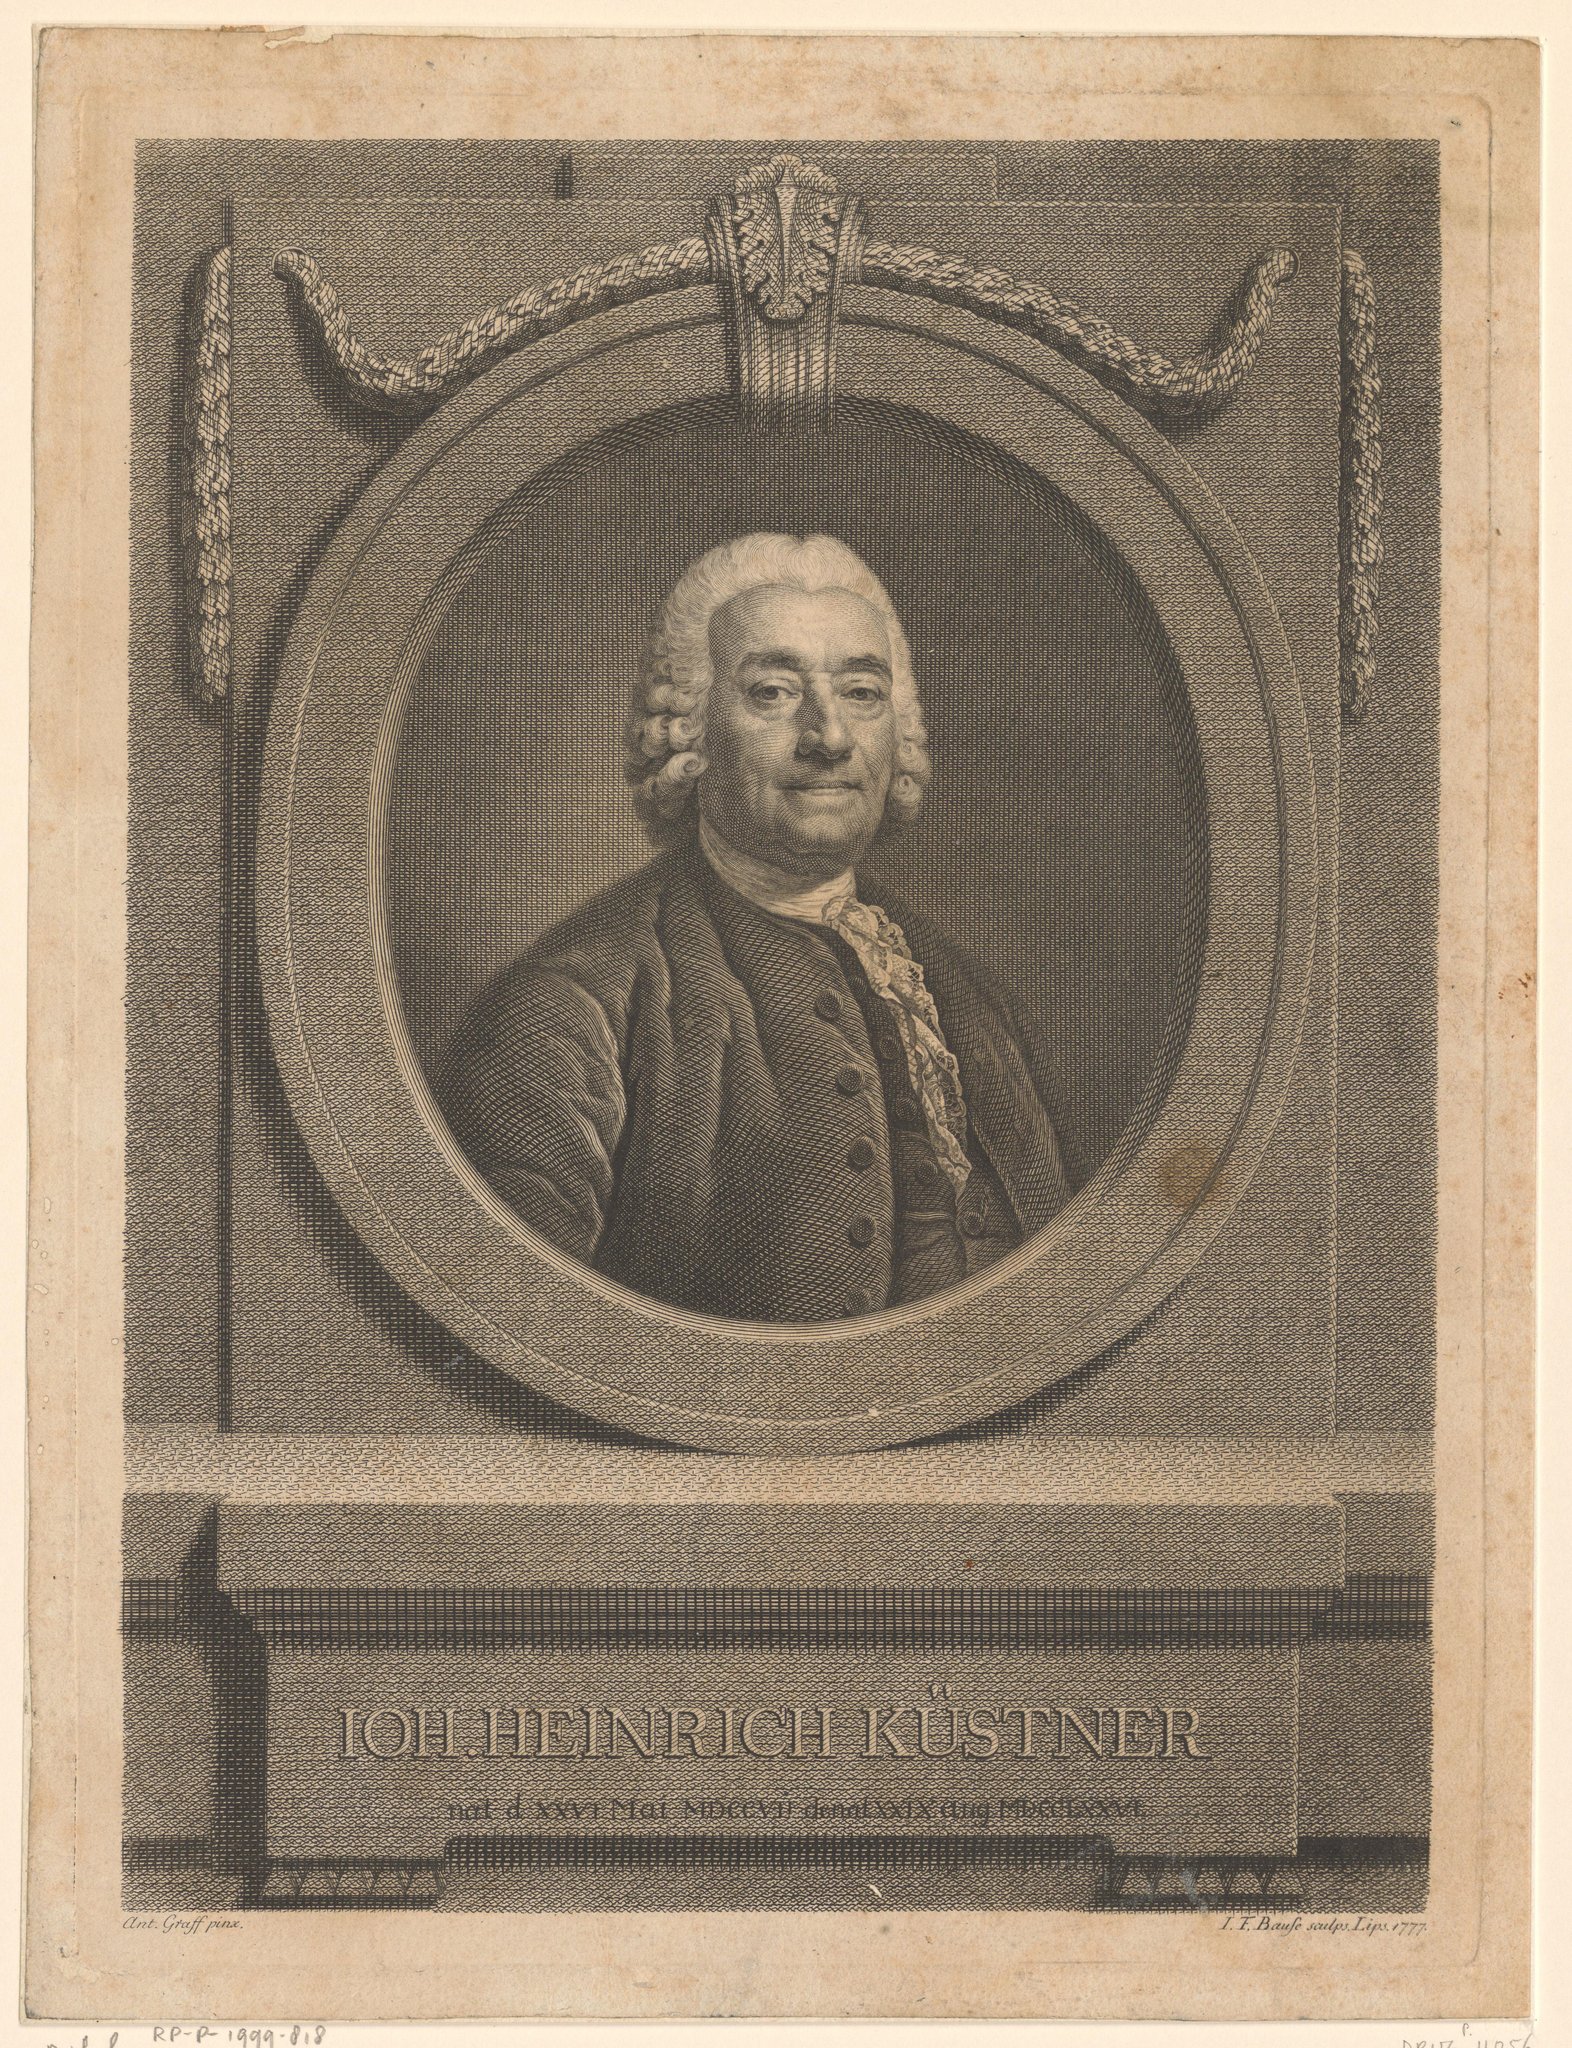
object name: print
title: Portret Johan Heinrich Küstner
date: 1777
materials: paper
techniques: engraving, etching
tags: banker, historical persons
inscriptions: collector's mark: Lugt 2228